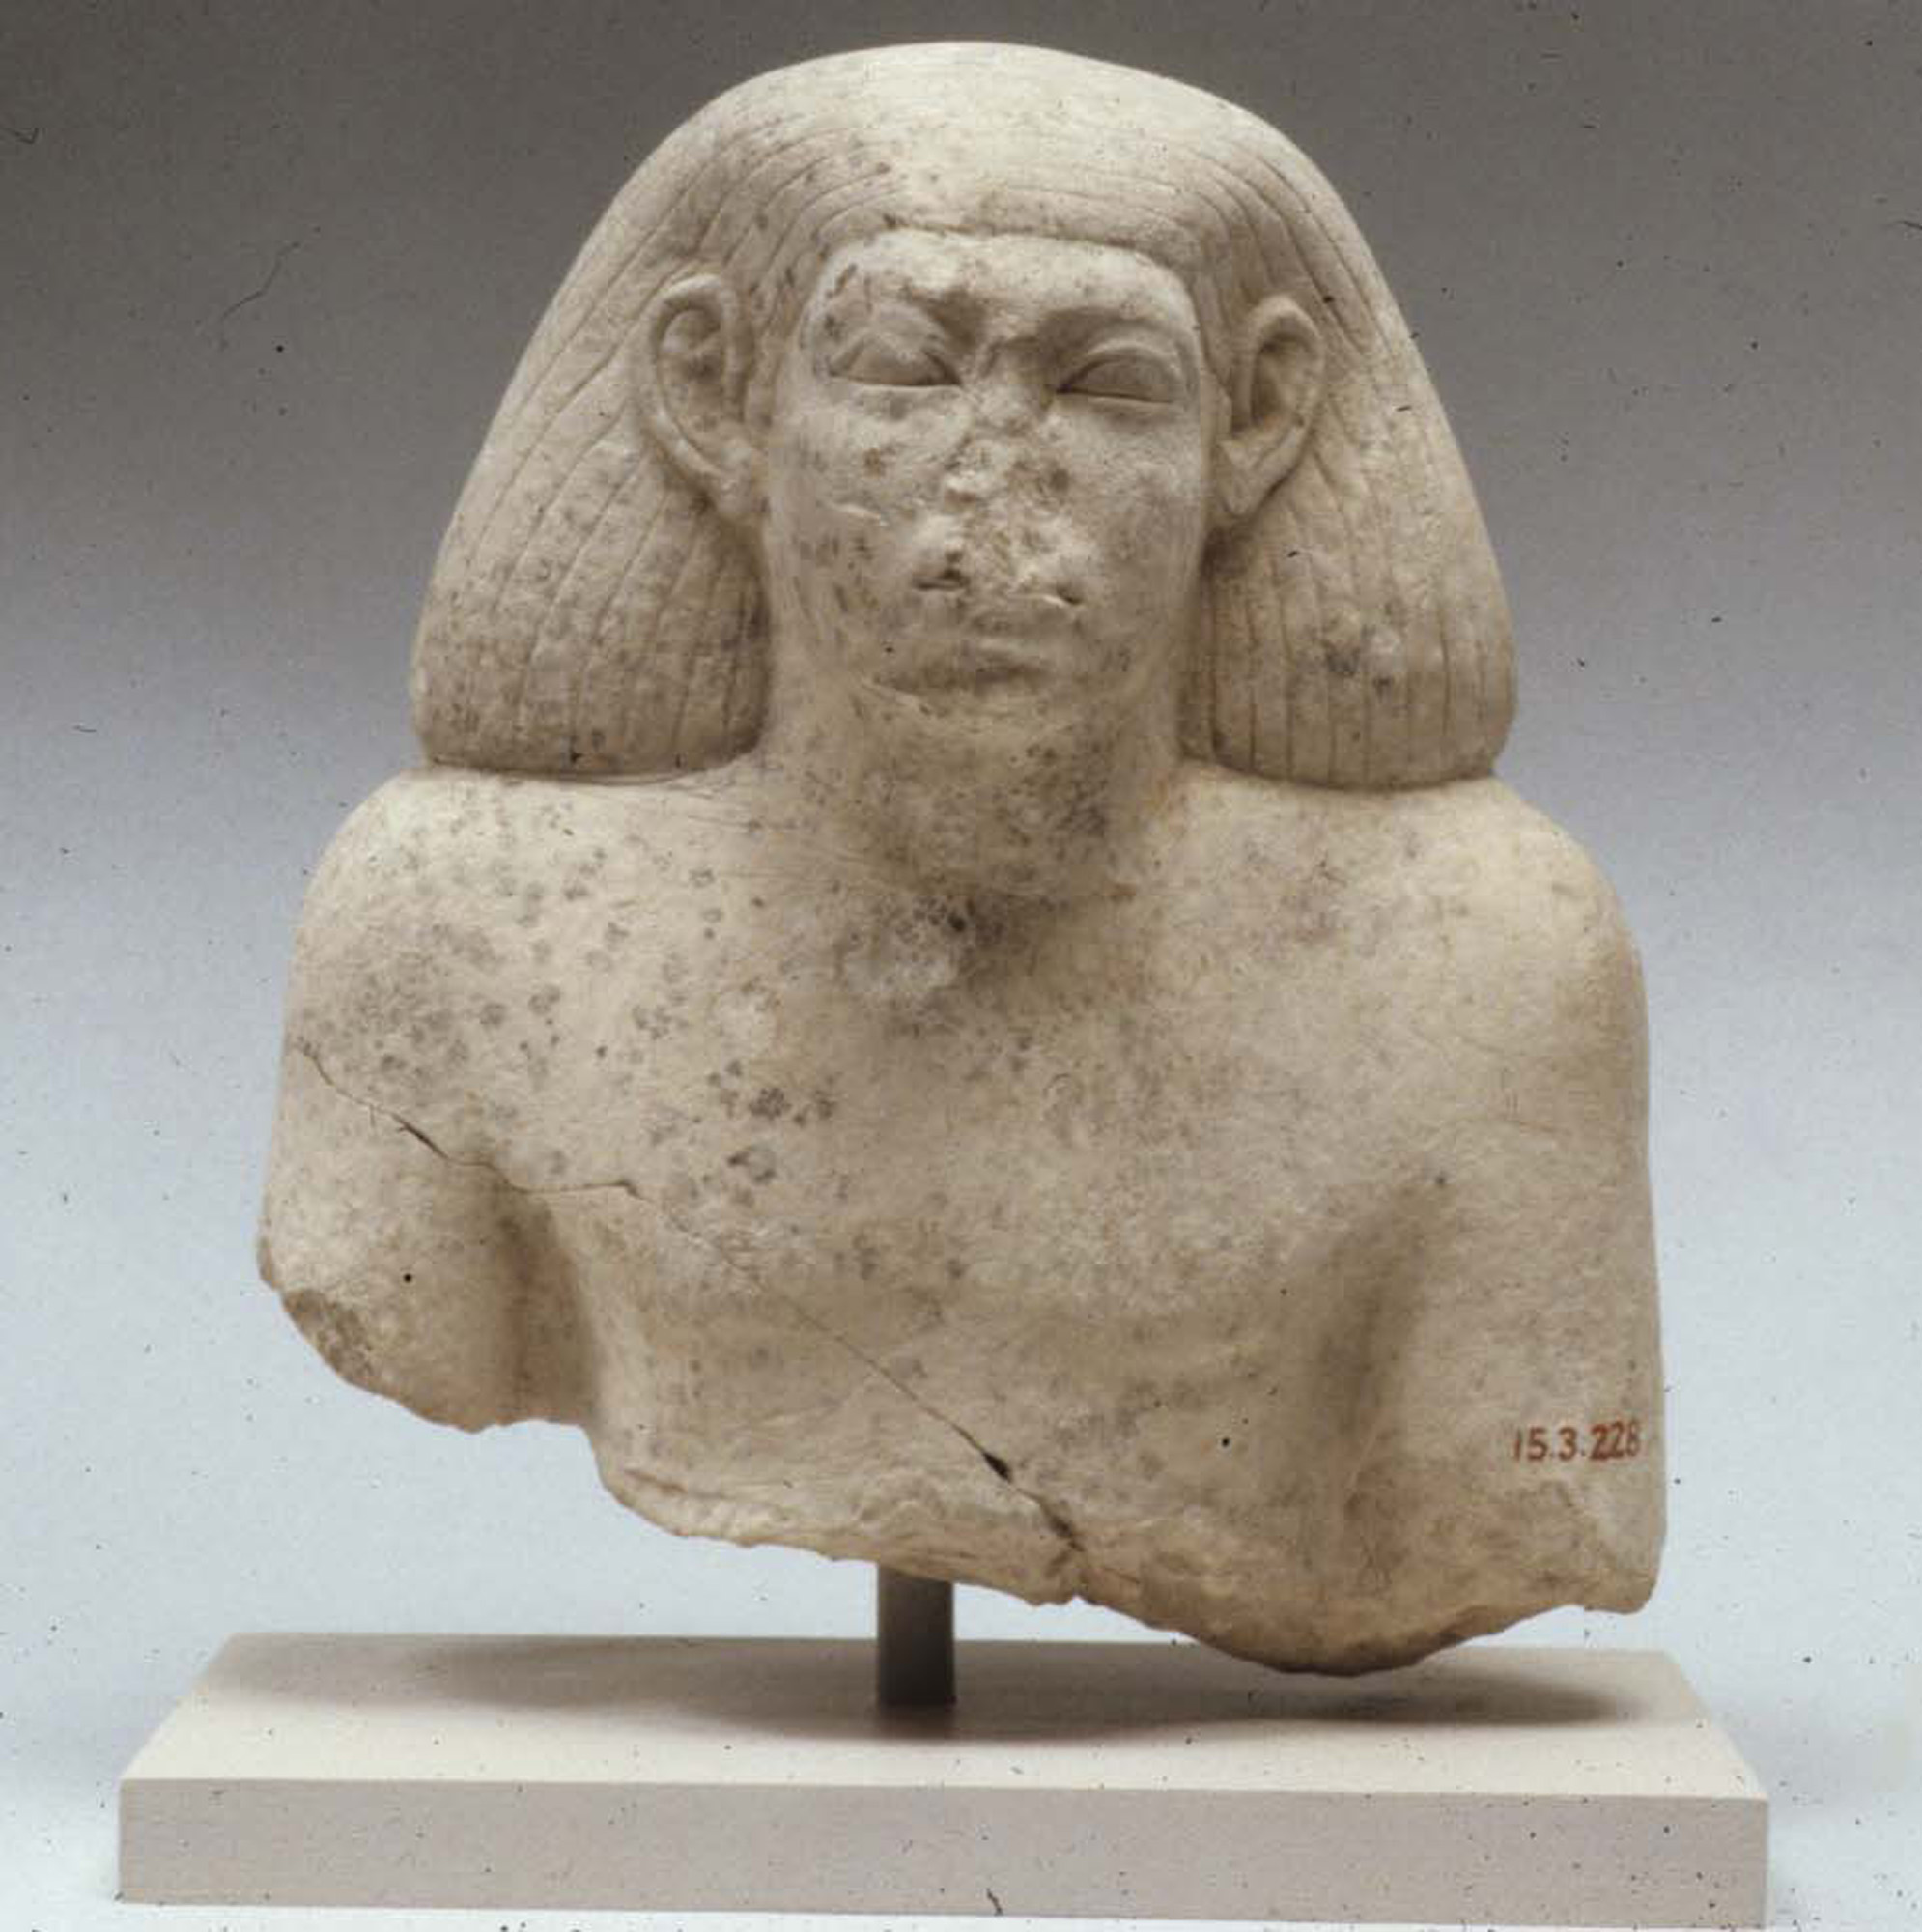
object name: bust, male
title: Upper part of male statue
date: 1850-1640 BCE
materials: limestone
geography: egypt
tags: men